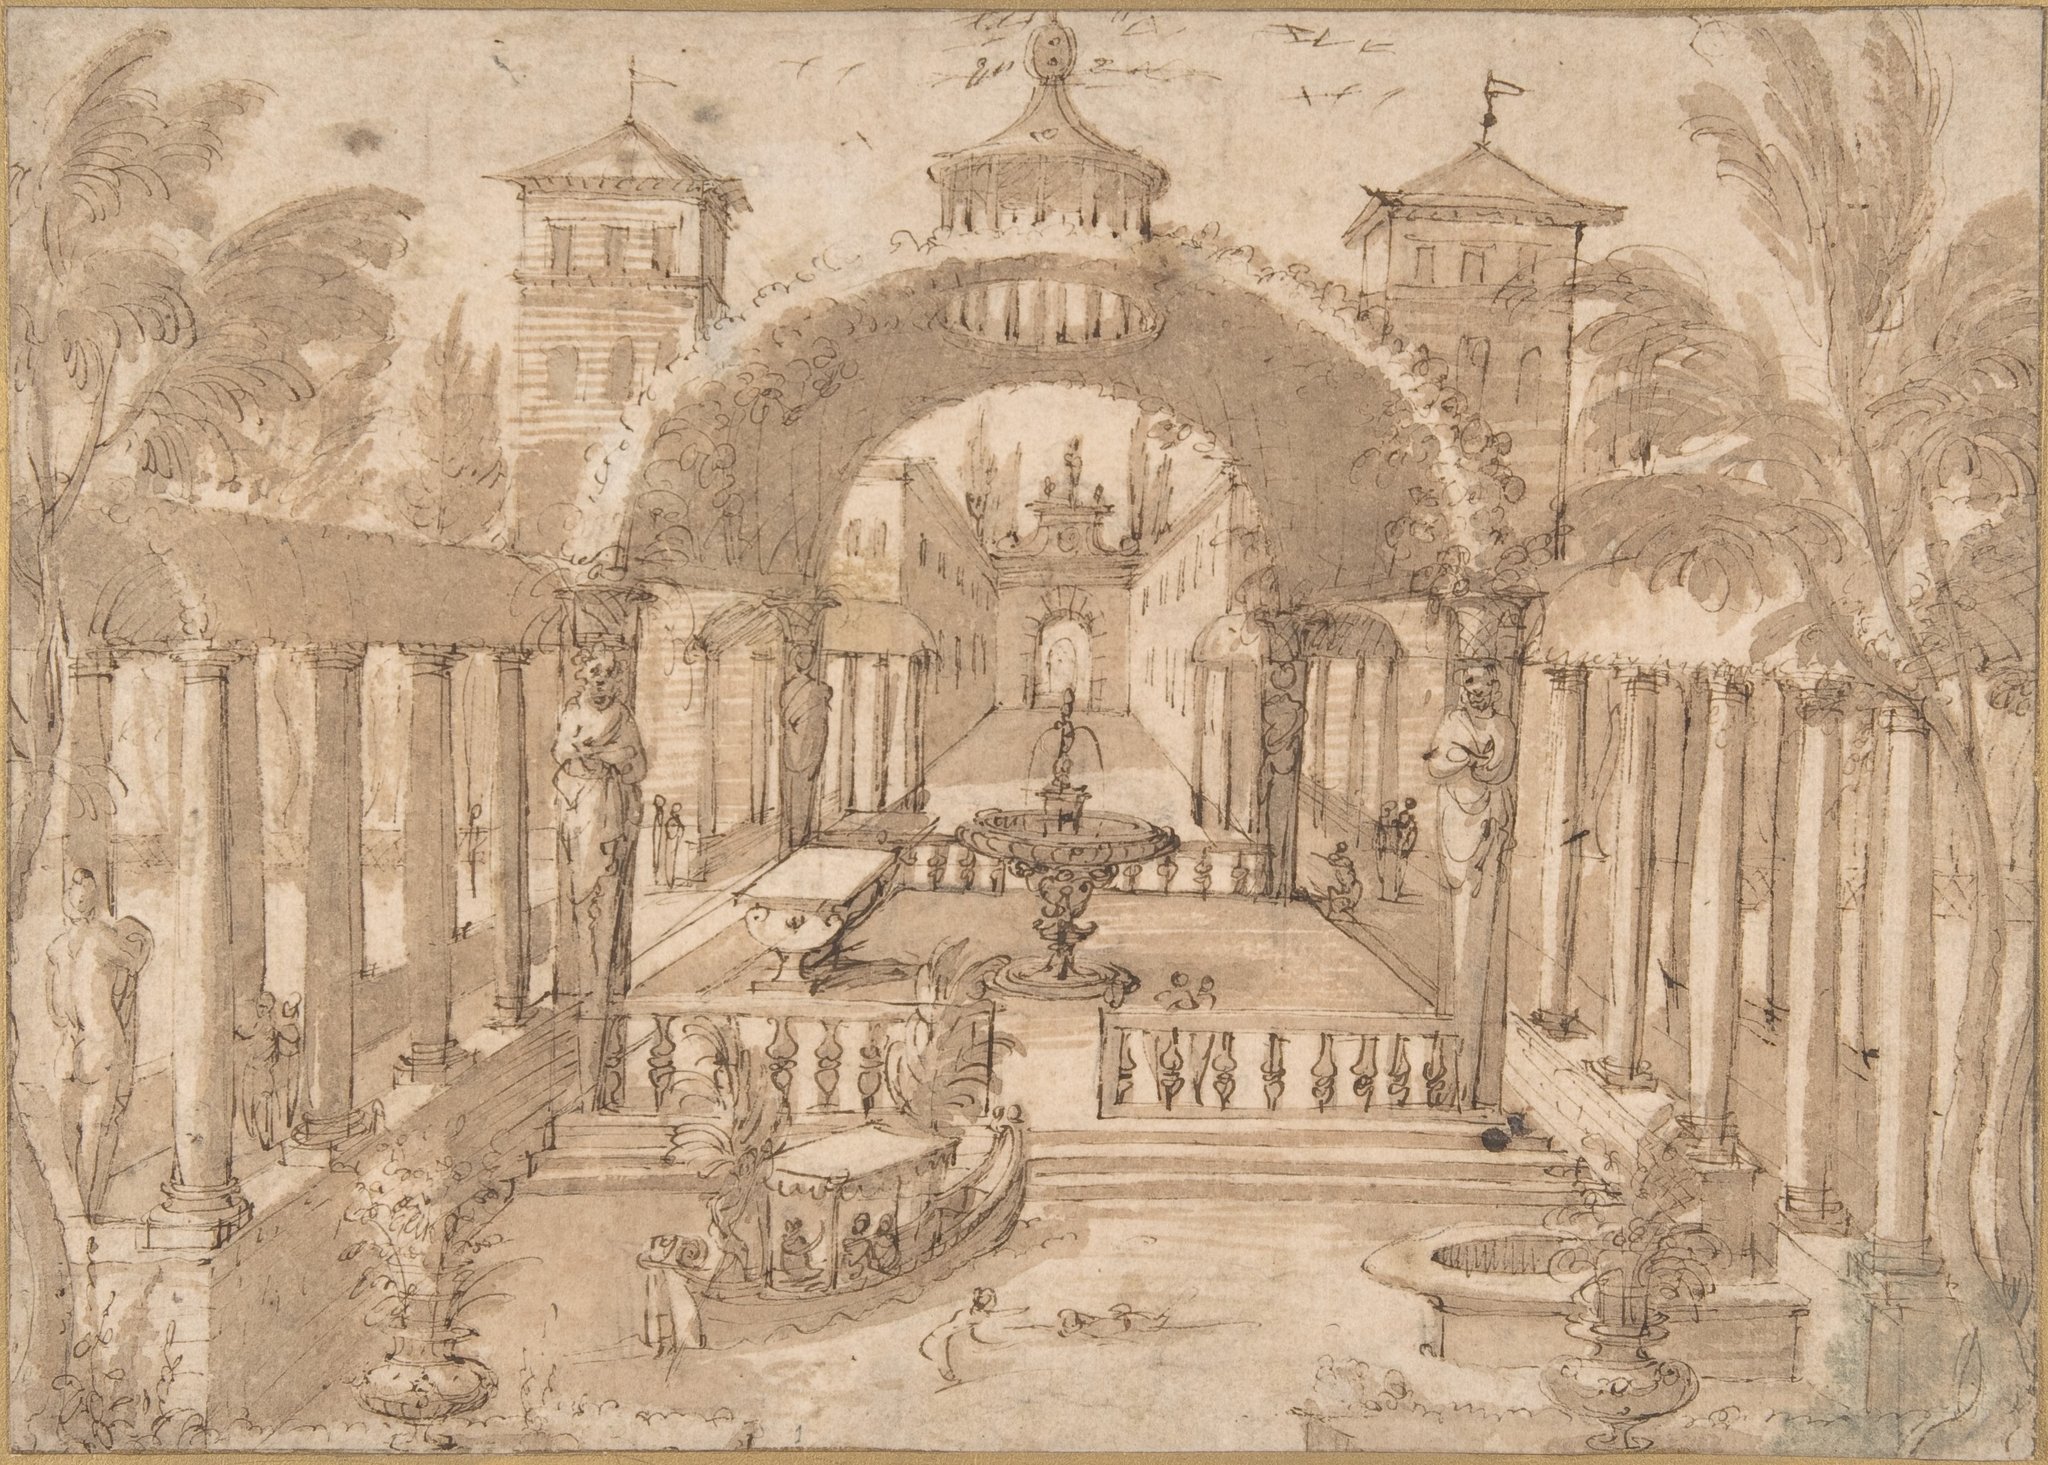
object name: drawing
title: View of the Gardens of a Palace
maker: lodewijk toeput (called pozzoserrato)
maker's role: artist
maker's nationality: netherlandish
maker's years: 1550-1603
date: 1534-1633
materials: chalk, ink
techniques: brush, pen, wash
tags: fountains,palaces,gardens,boats